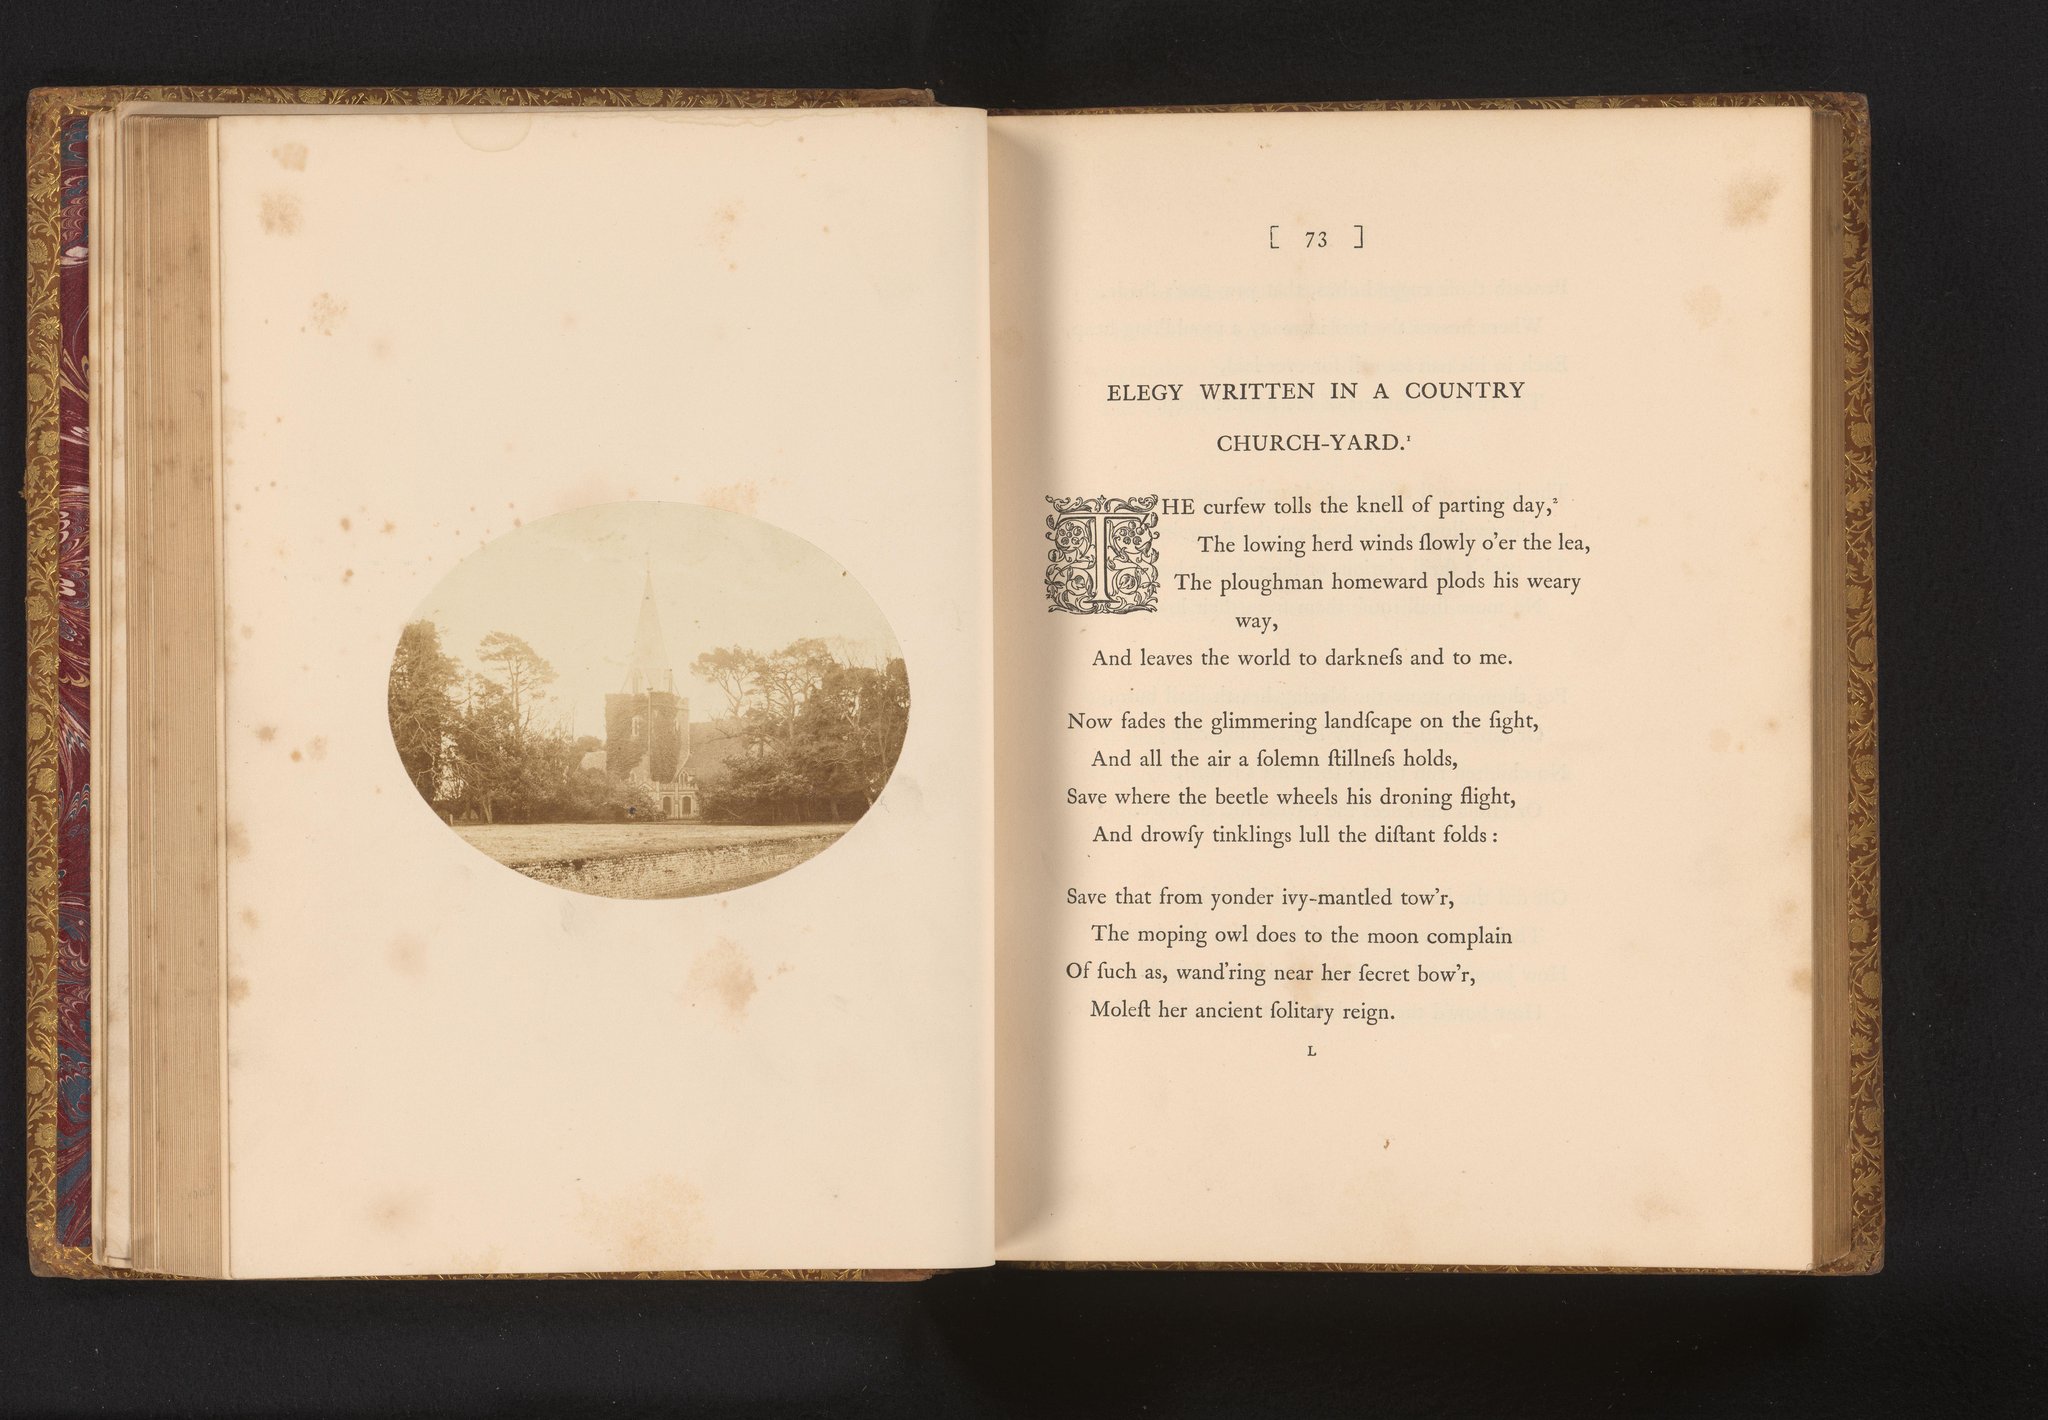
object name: page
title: Gezicht op een begroeide kerk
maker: Anonymous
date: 1859-1863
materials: paper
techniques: albumen print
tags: church (exterior)